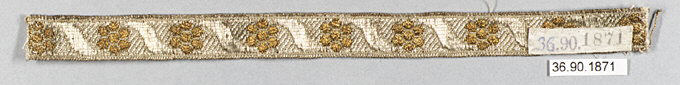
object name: galloon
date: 1767-1833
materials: metal thread, silk